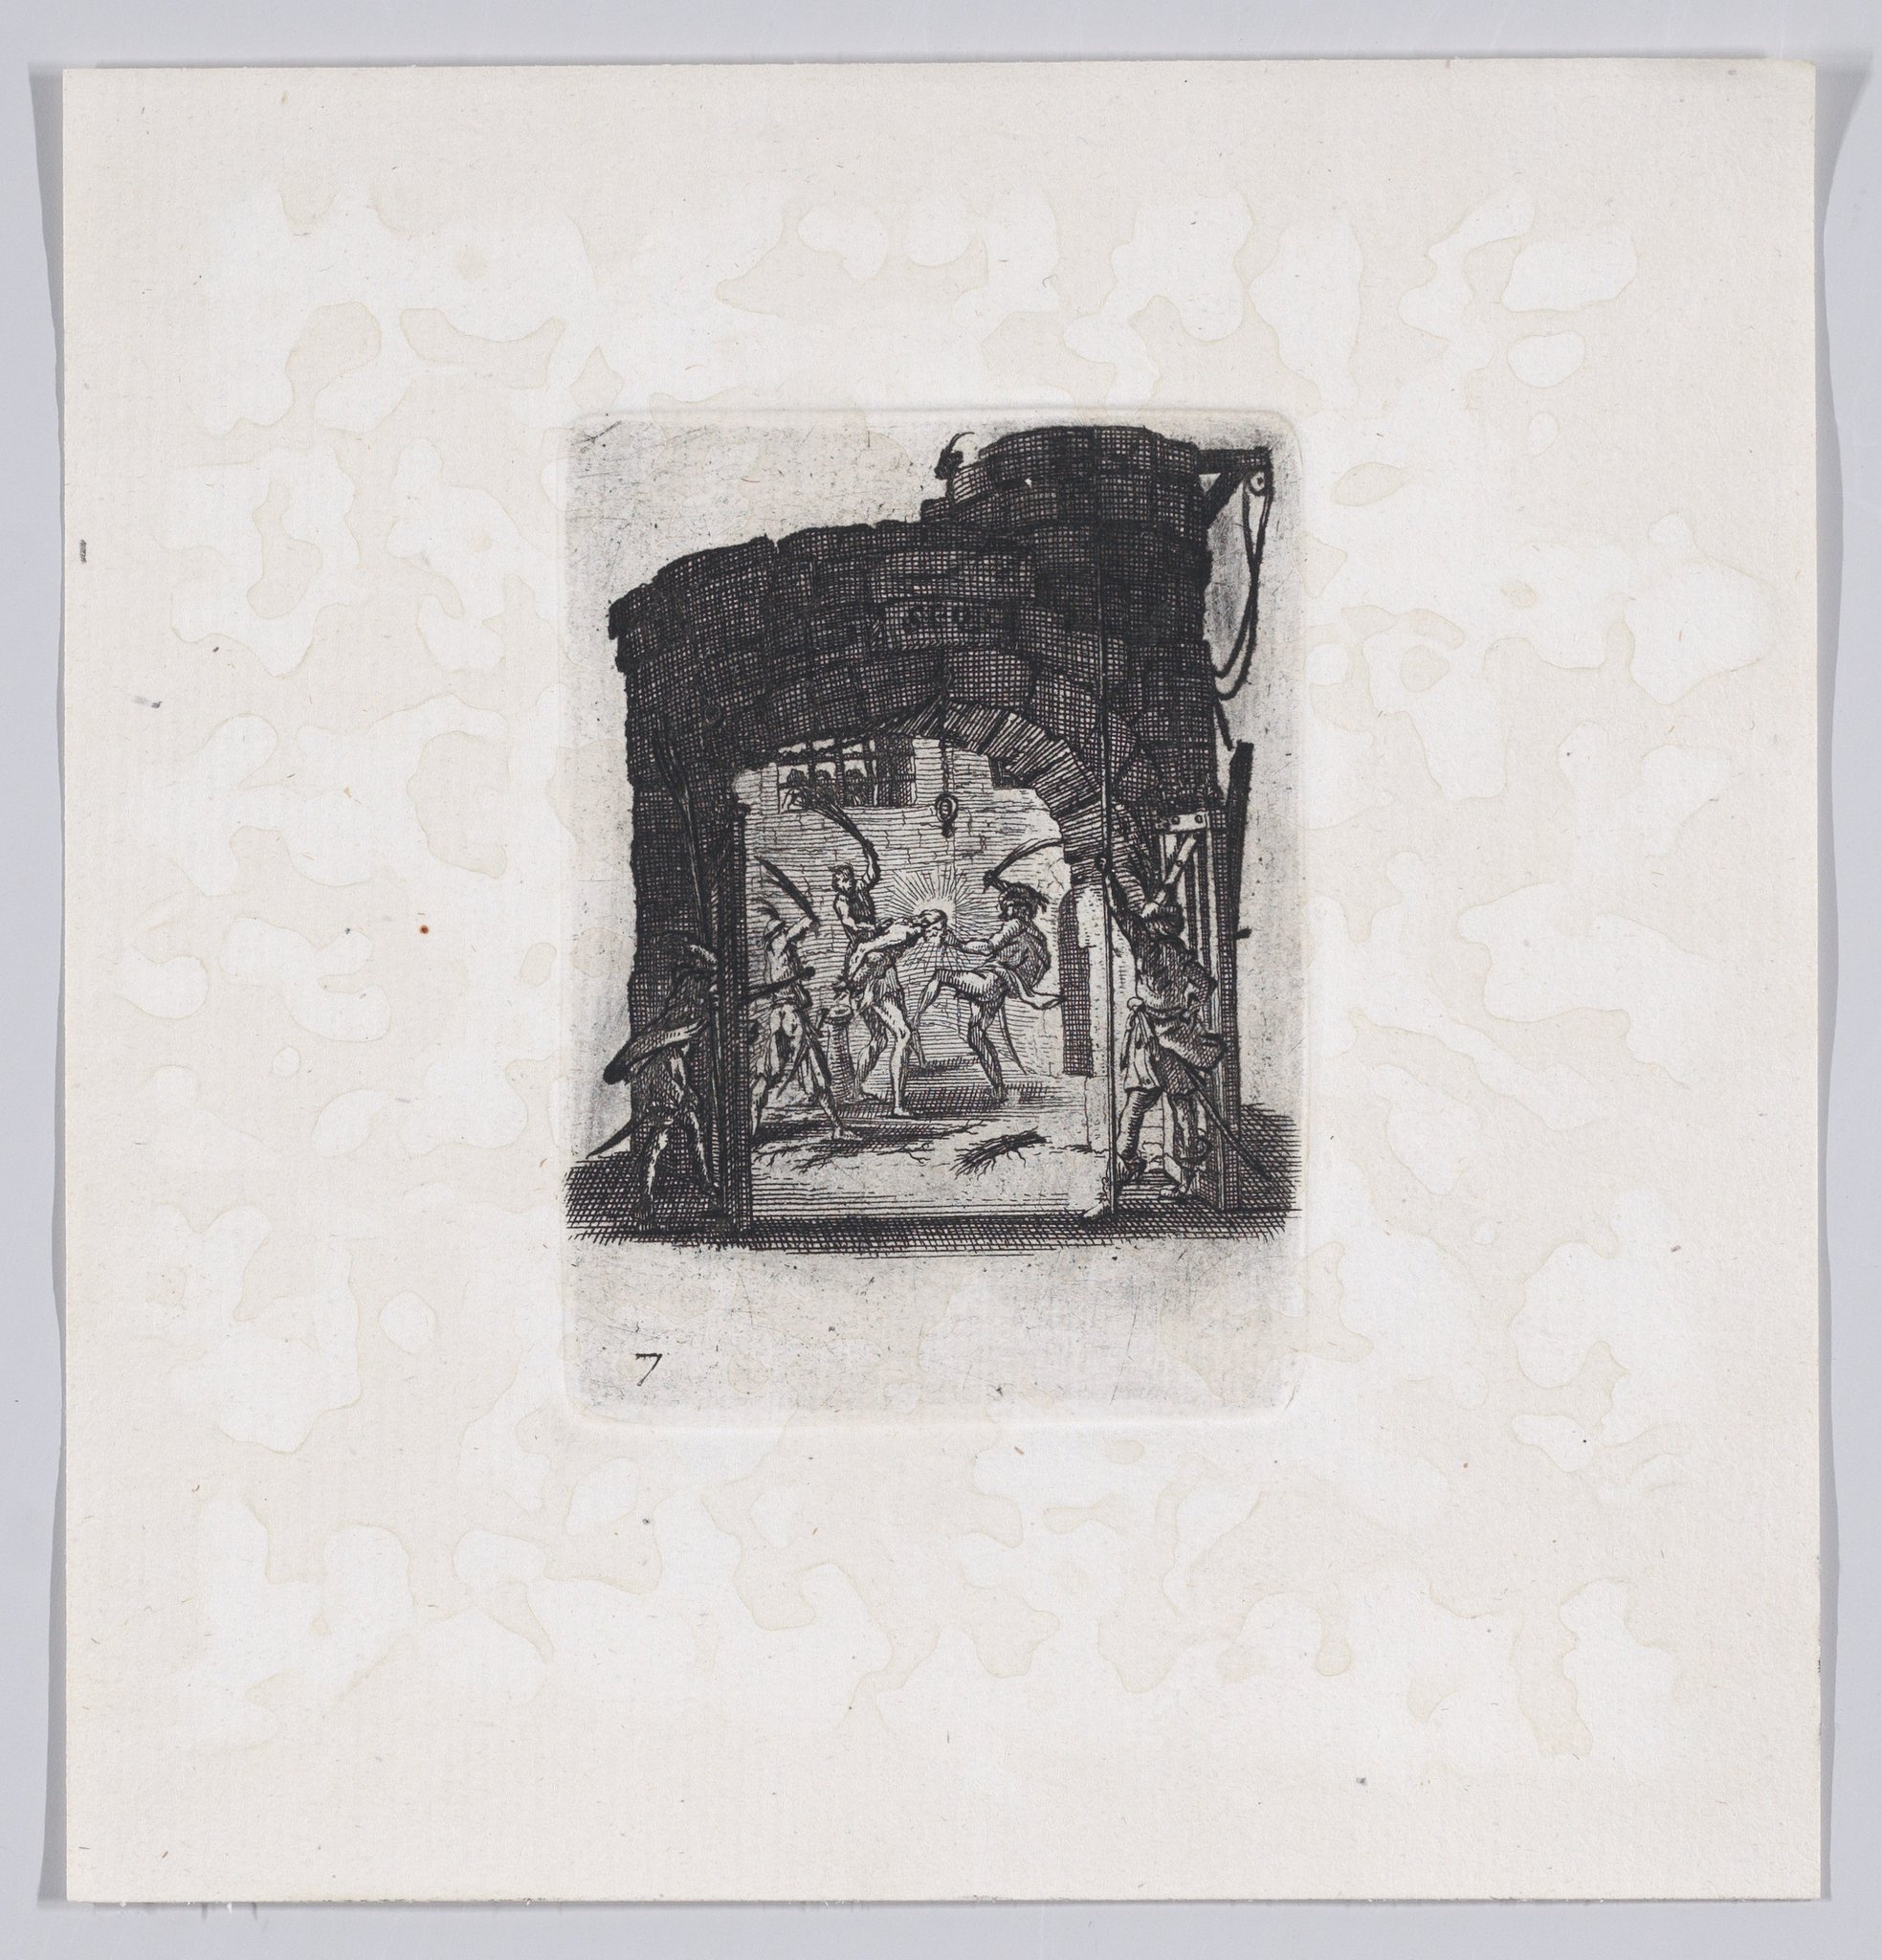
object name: print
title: Reverse Copy of Jésus est Battu de Verges pièce appelée aussi La Flagellation (The Flagellation), from La Petite Passion (The Little Passion)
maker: Anonymous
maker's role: artist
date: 1601-1700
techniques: etching